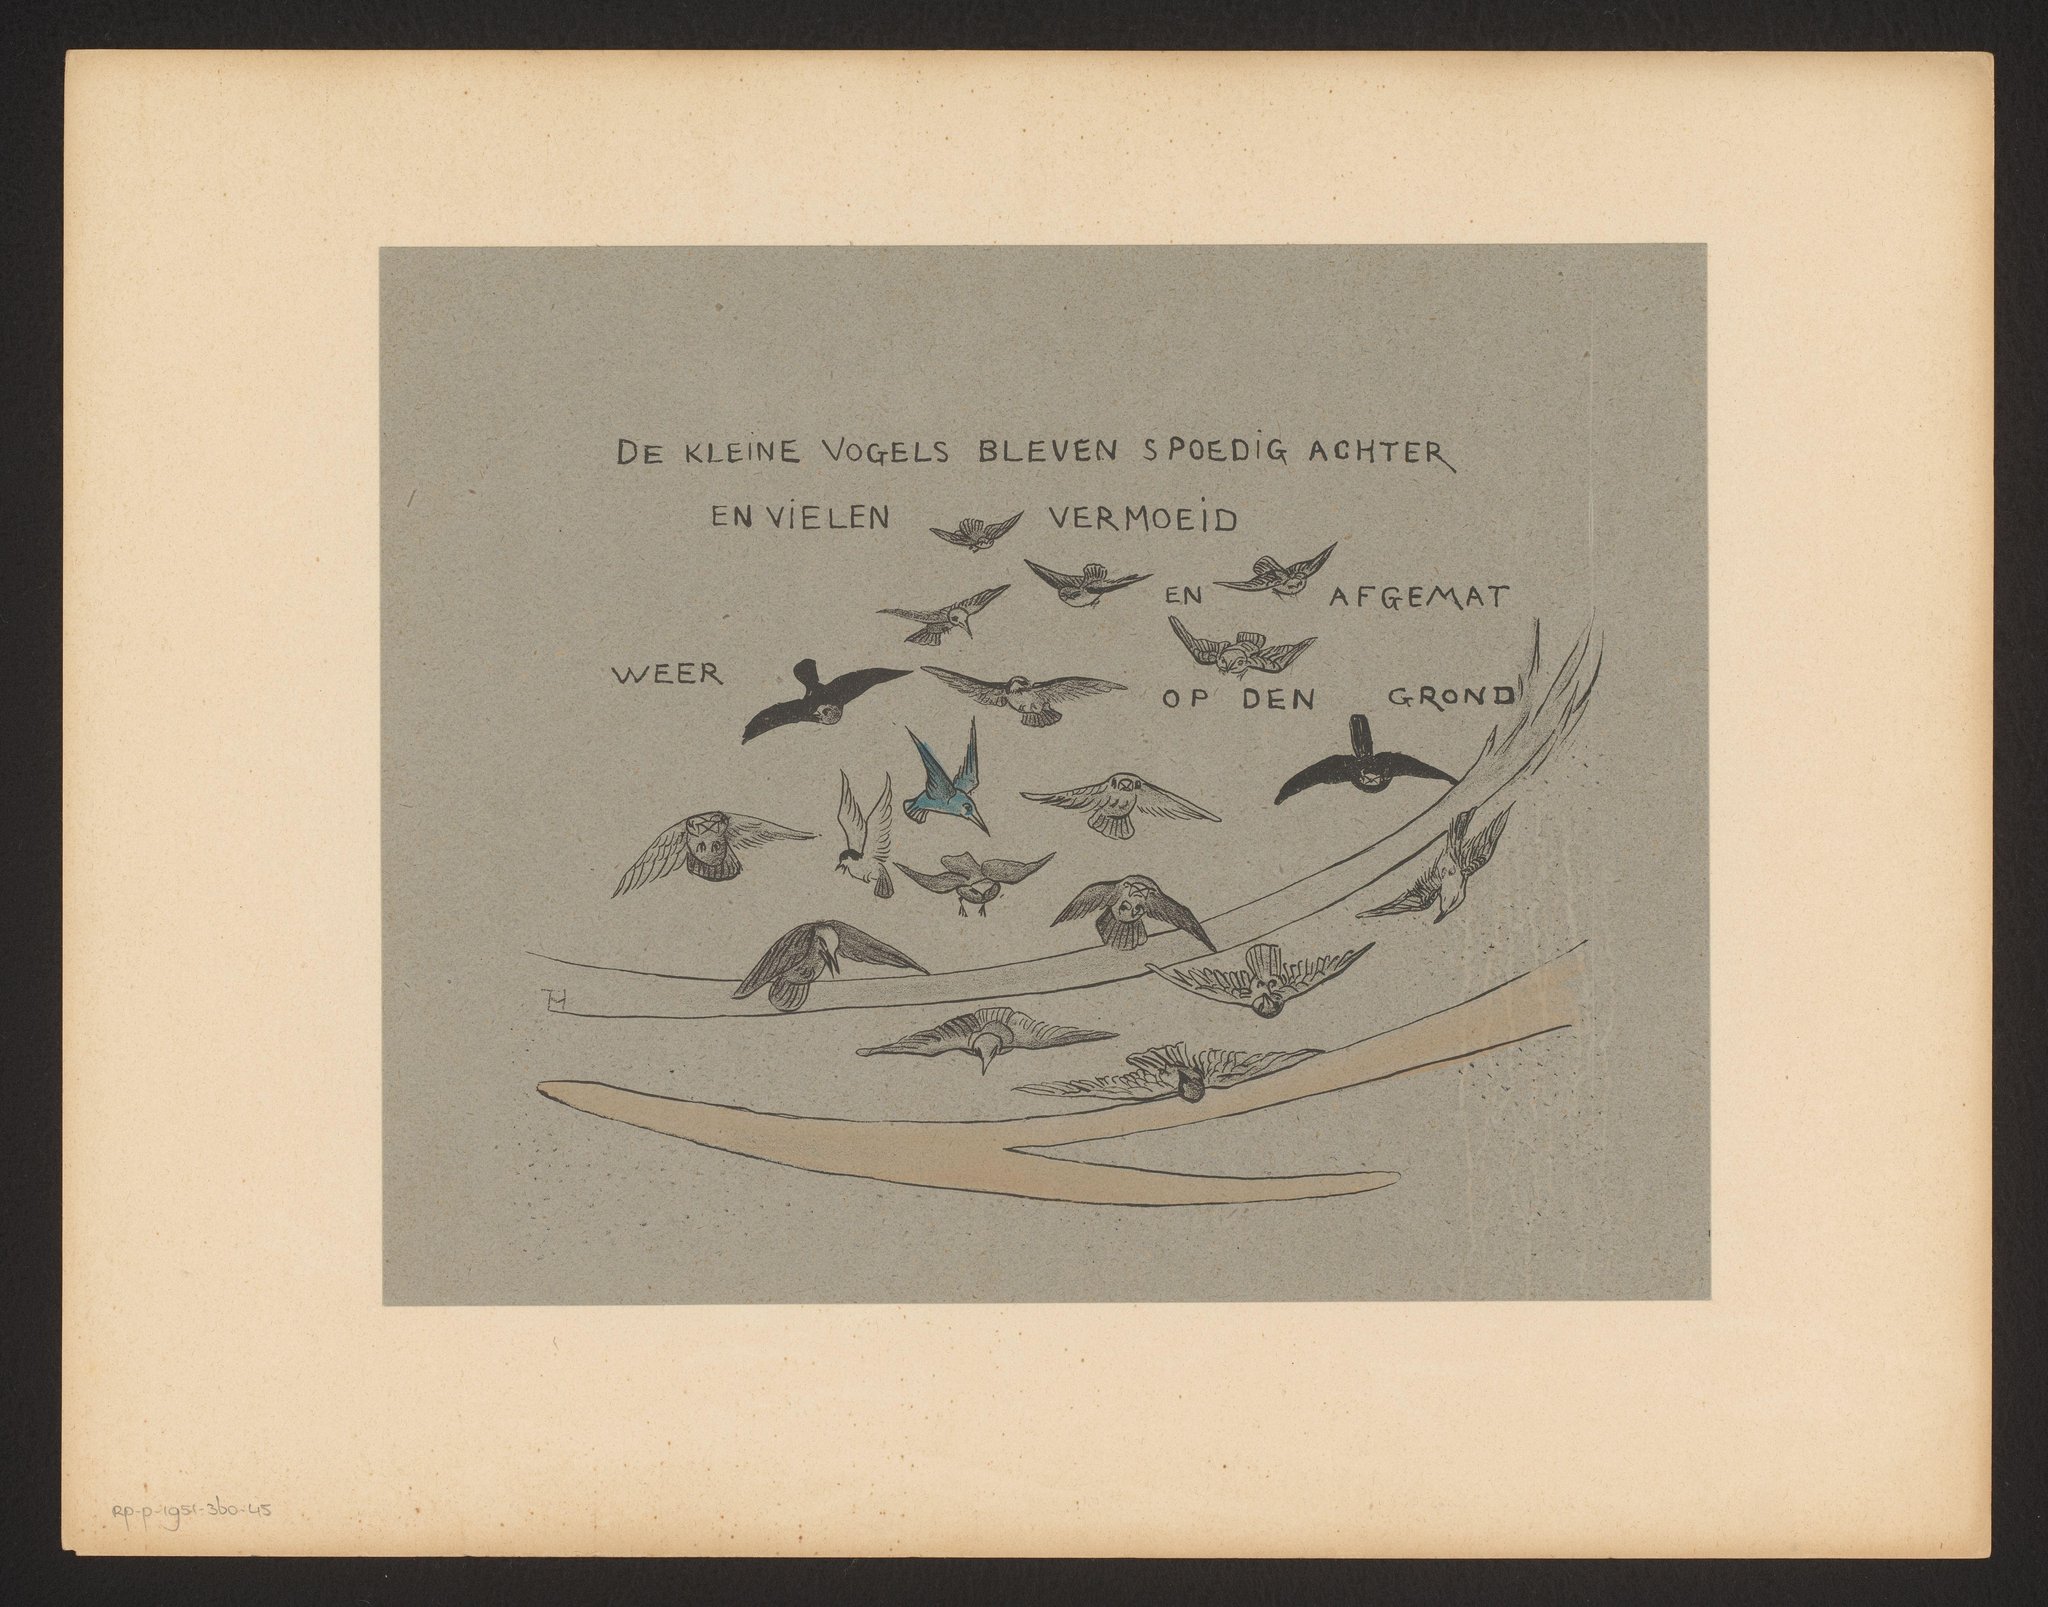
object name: print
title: Hoe de vogels aan een koning kwamen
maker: theo van hoytema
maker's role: draughtsman, painter, print maker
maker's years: 1863-1917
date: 1892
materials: paper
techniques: hand coloring, lithograph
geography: the hague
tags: groups of birds